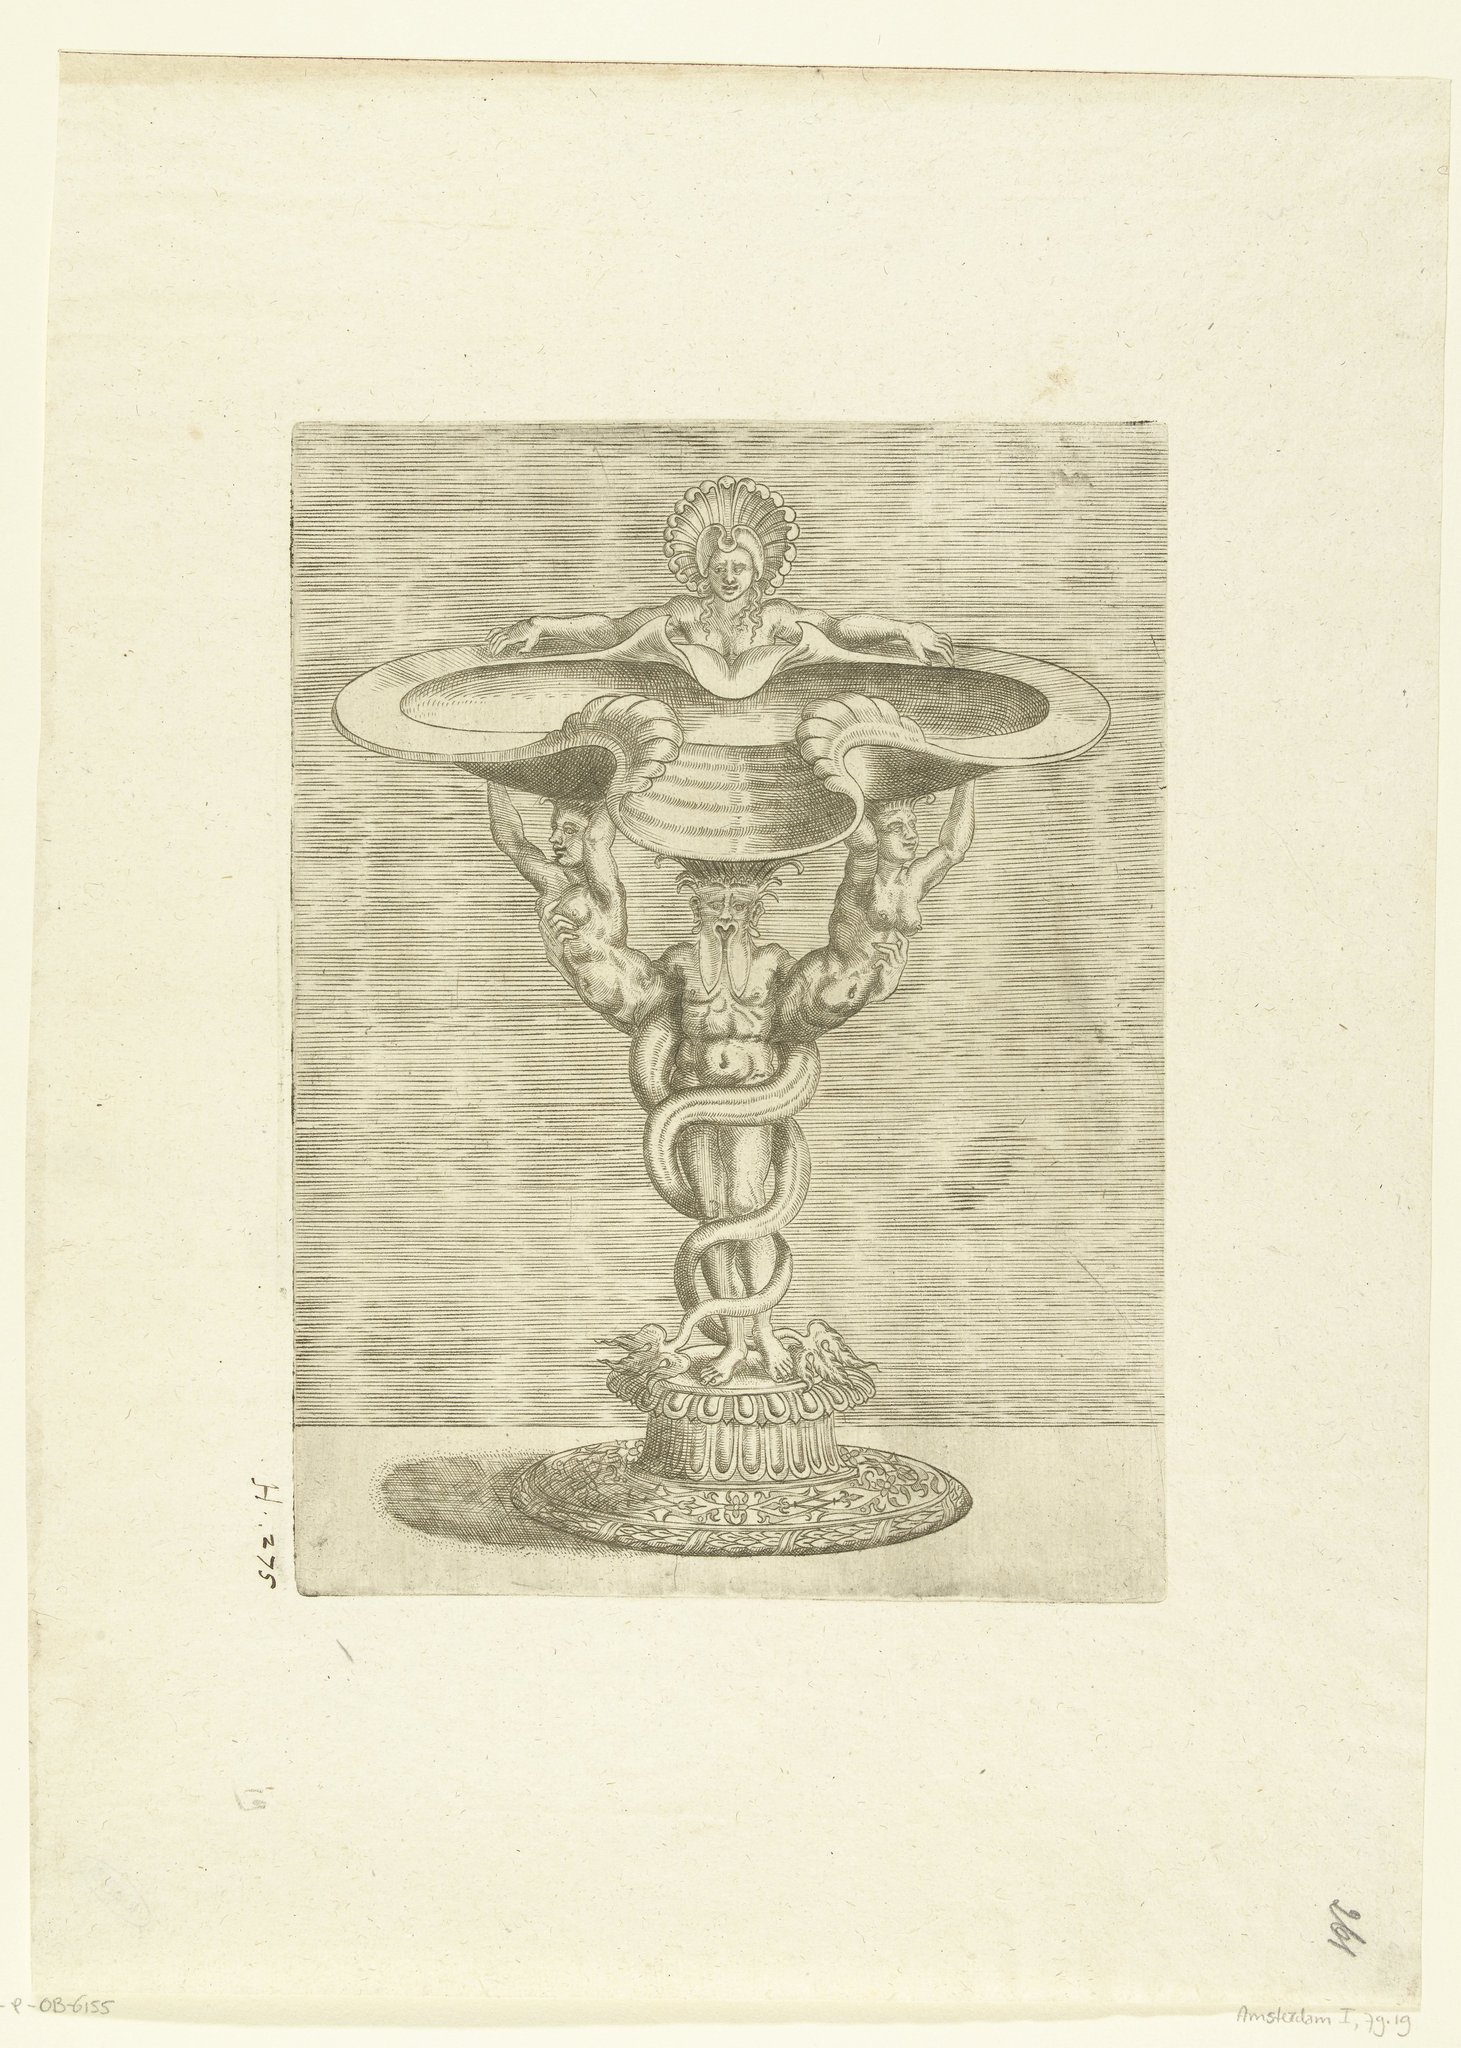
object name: print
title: Vazen, kannen en schalen met grotesken.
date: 1548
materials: paper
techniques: engraving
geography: netherlands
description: Schaal op een voet, gevormd door een man en twee zeemeerminnen die hij draagt en van wie de staarten om zijn benen gewonden zijn. Aan de achterzijde leunt een vrouw over de rand van de schaal. Afkomstig uit een serie bestaande uit een titelblad en 20 bladen.